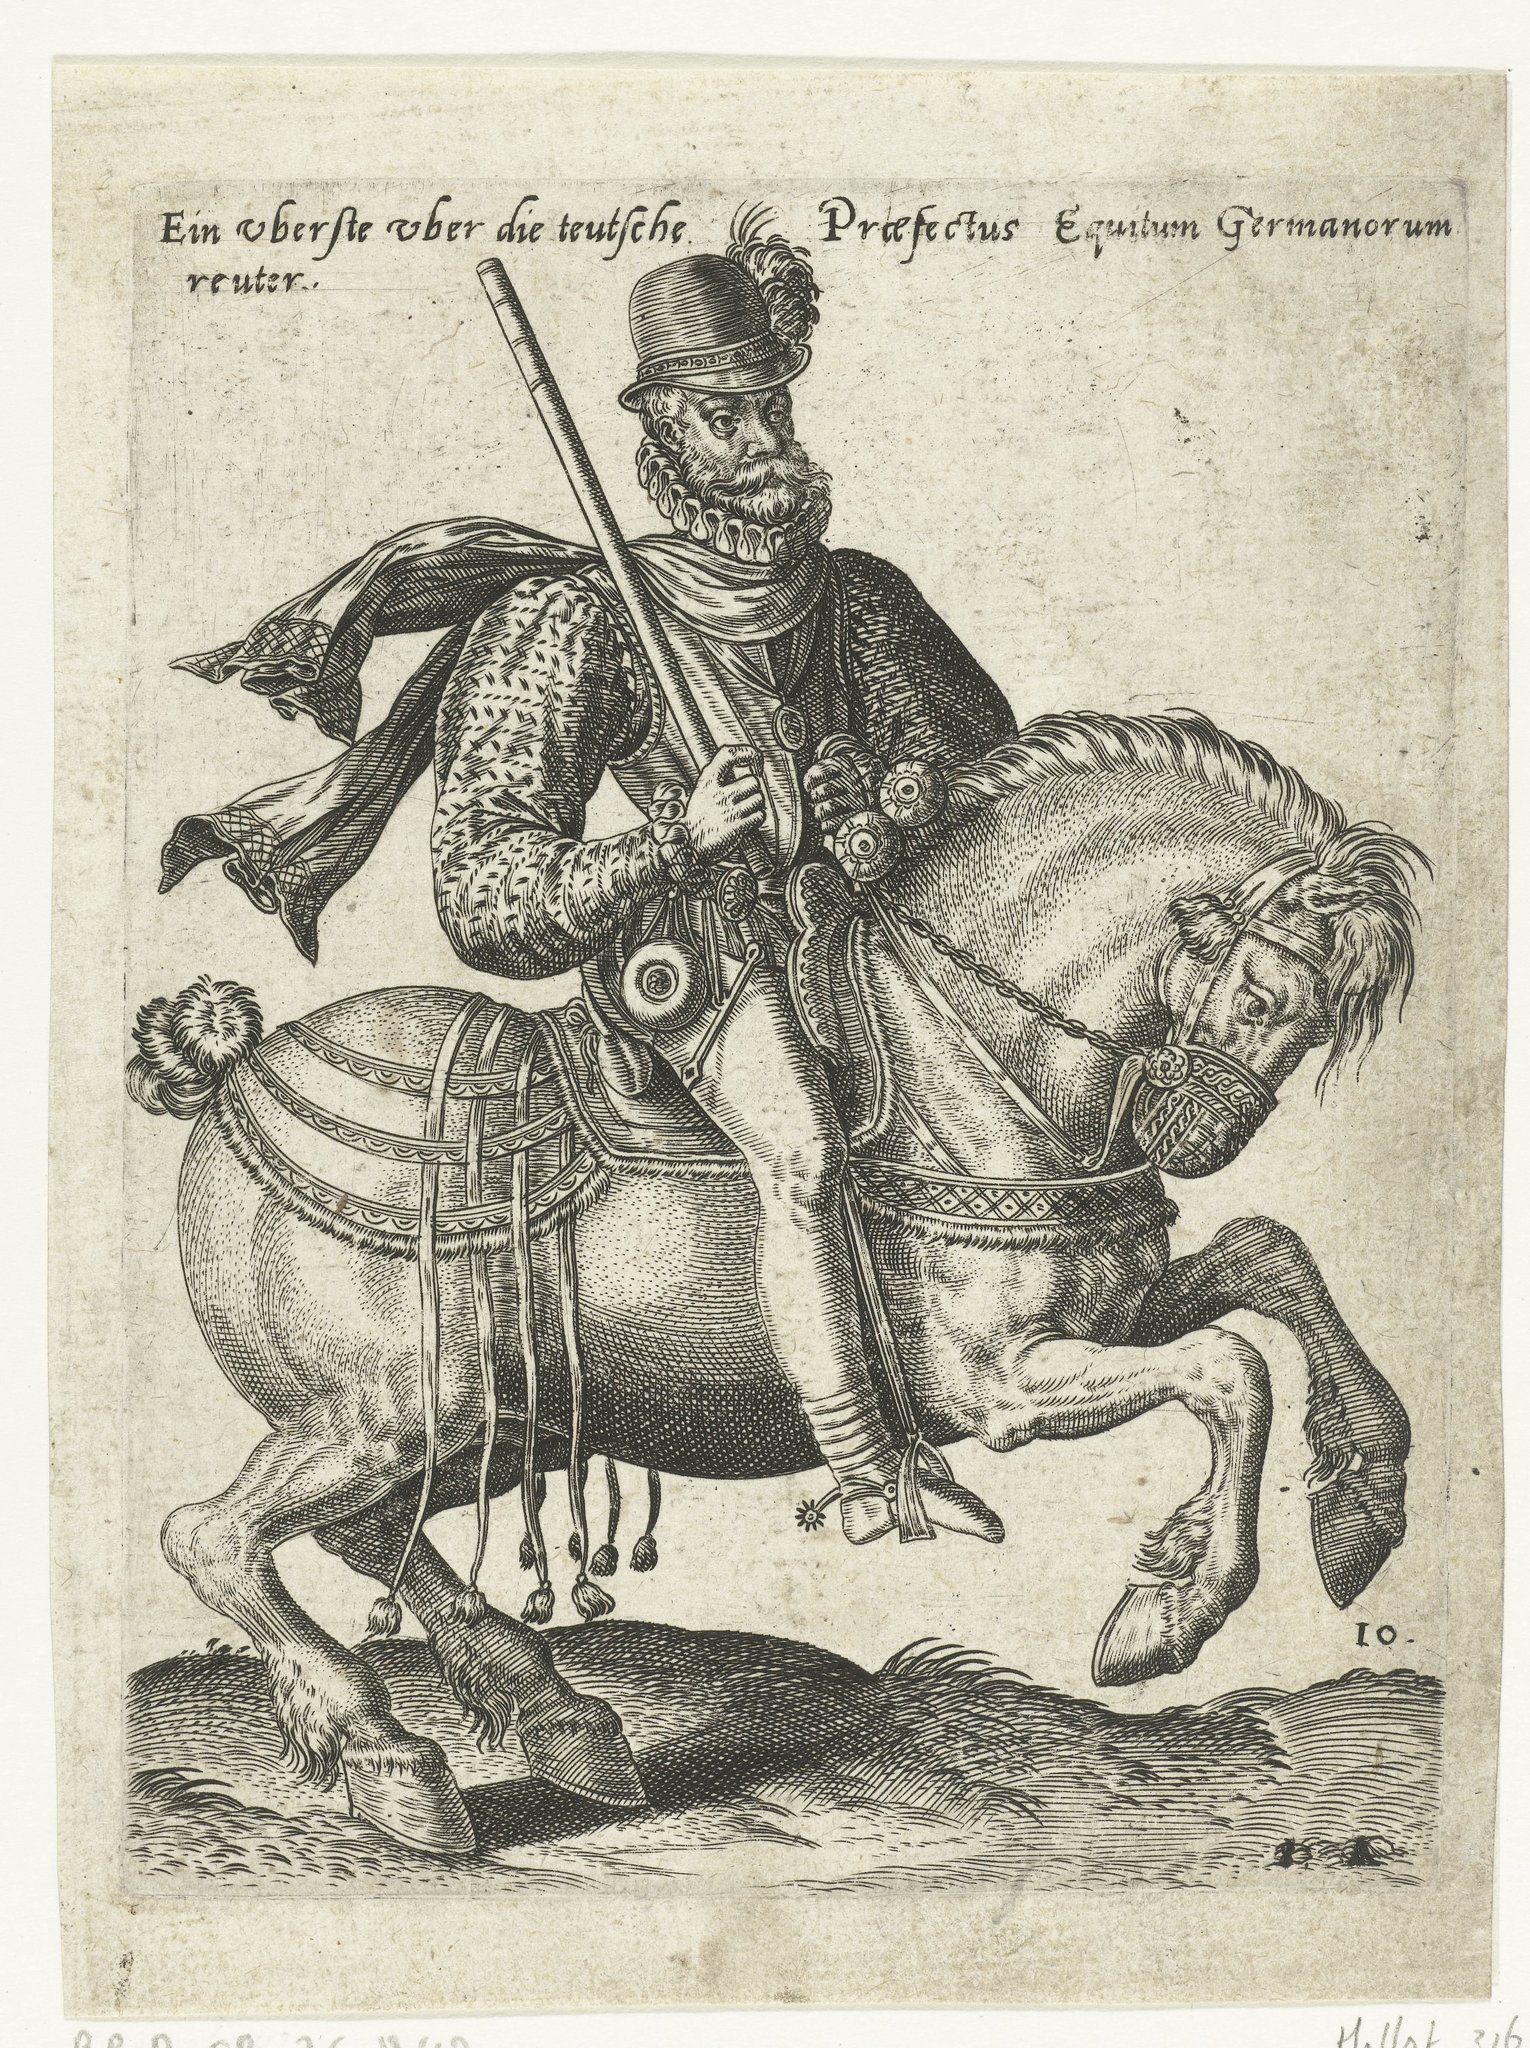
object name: costume print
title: Duitse ruiter-commandant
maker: abraham de bruyn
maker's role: print maker, publisher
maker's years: 1540-1587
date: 1577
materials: paper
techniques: engraving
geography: cologne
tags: commander-in-chief, general, marshal, warfare; military affairs (+ cavalry, horsemen), folk costume, regional costume, military clothing and other equipment (uniforms, cap, armour, helmet, etc.), baton of general, europeans: germans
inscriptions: collector's mark: Lugt 2228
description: Prent oorspronkelijk verschenen in 'Equitum descripcio, quomodo equestres copie, nostra hac aetate, in sua armatura, per cunttas, videlicet Europae, Asiae et Affrice, nationes in re militare sese habent nunc primum', Keulen 1577.